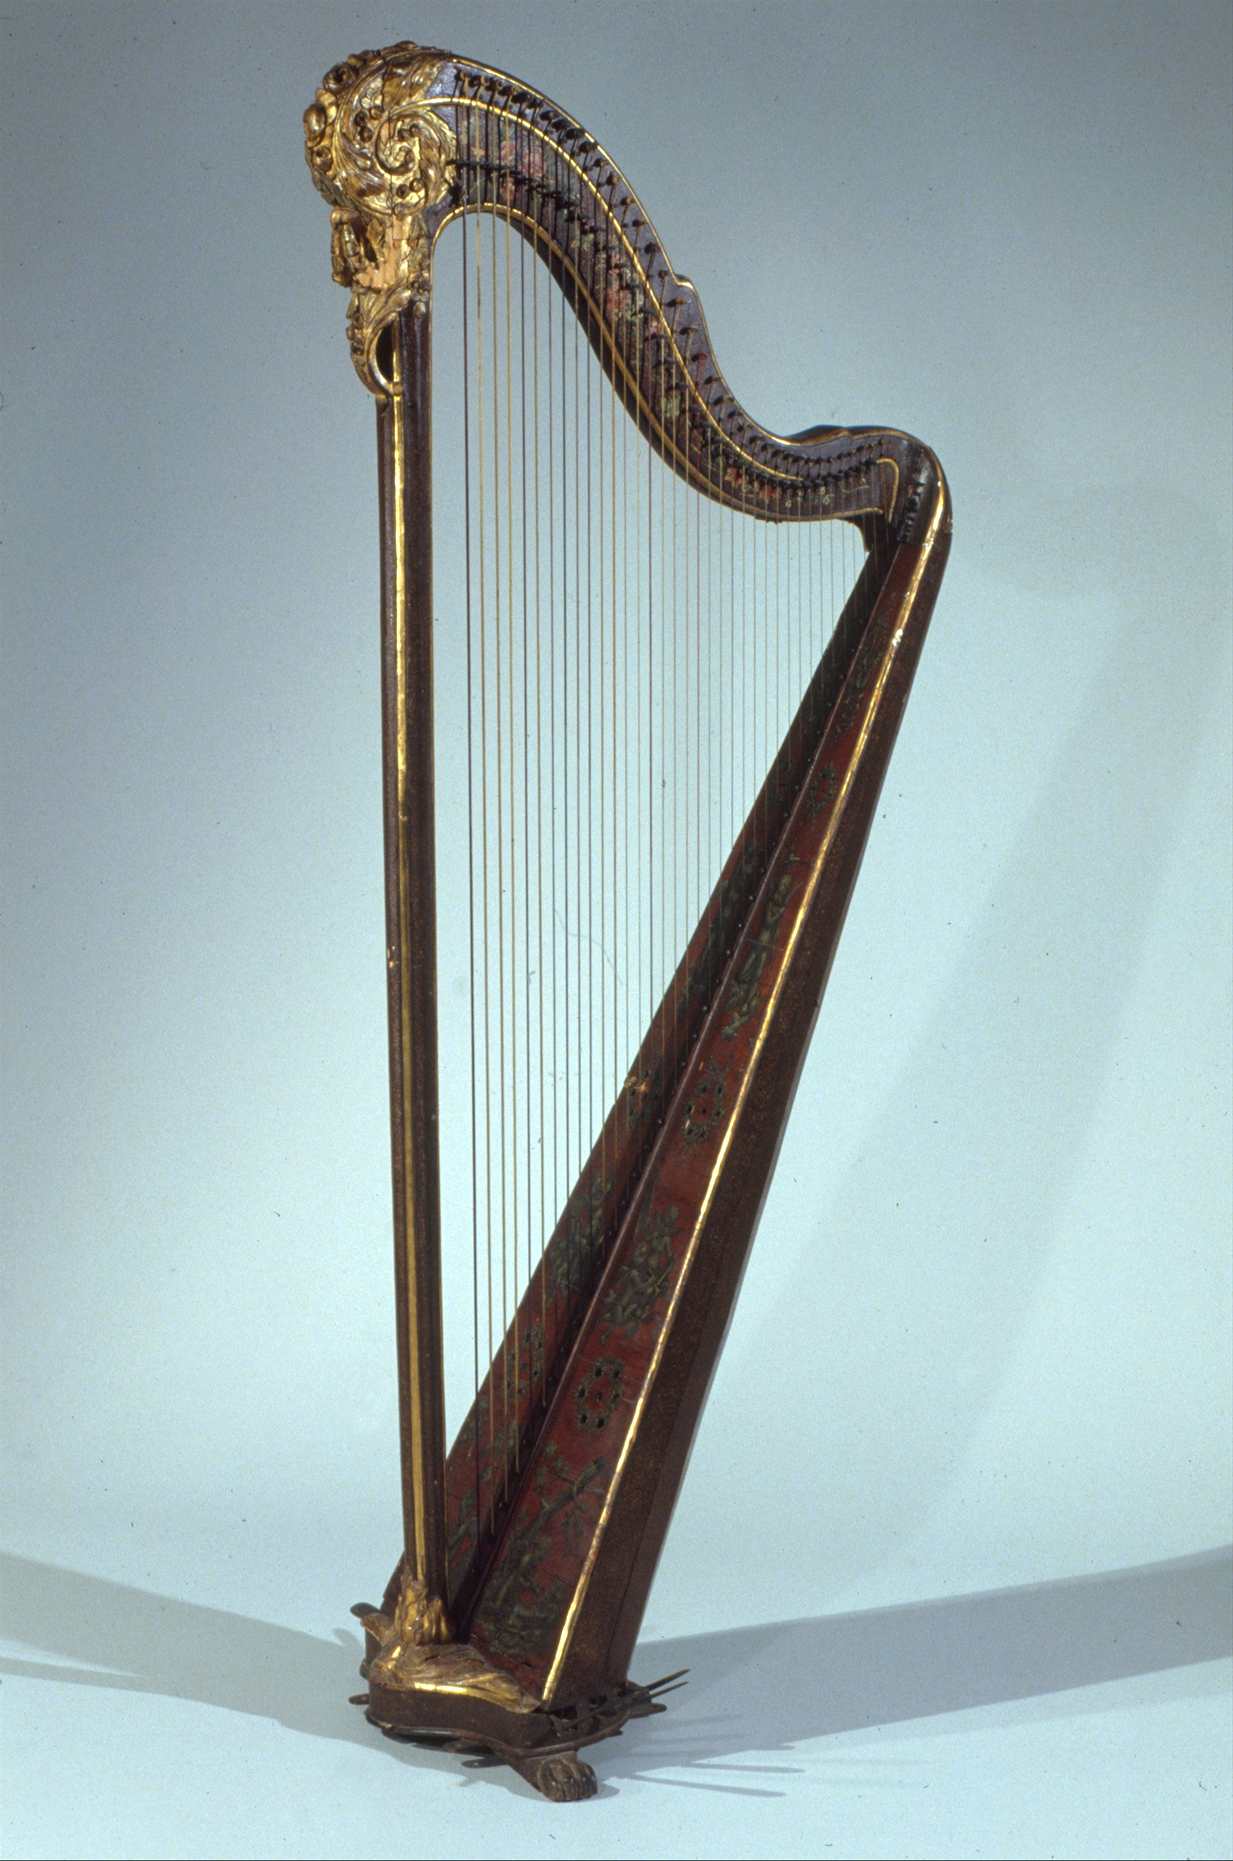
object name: pedal harp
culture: french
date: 1800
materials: wood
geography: france